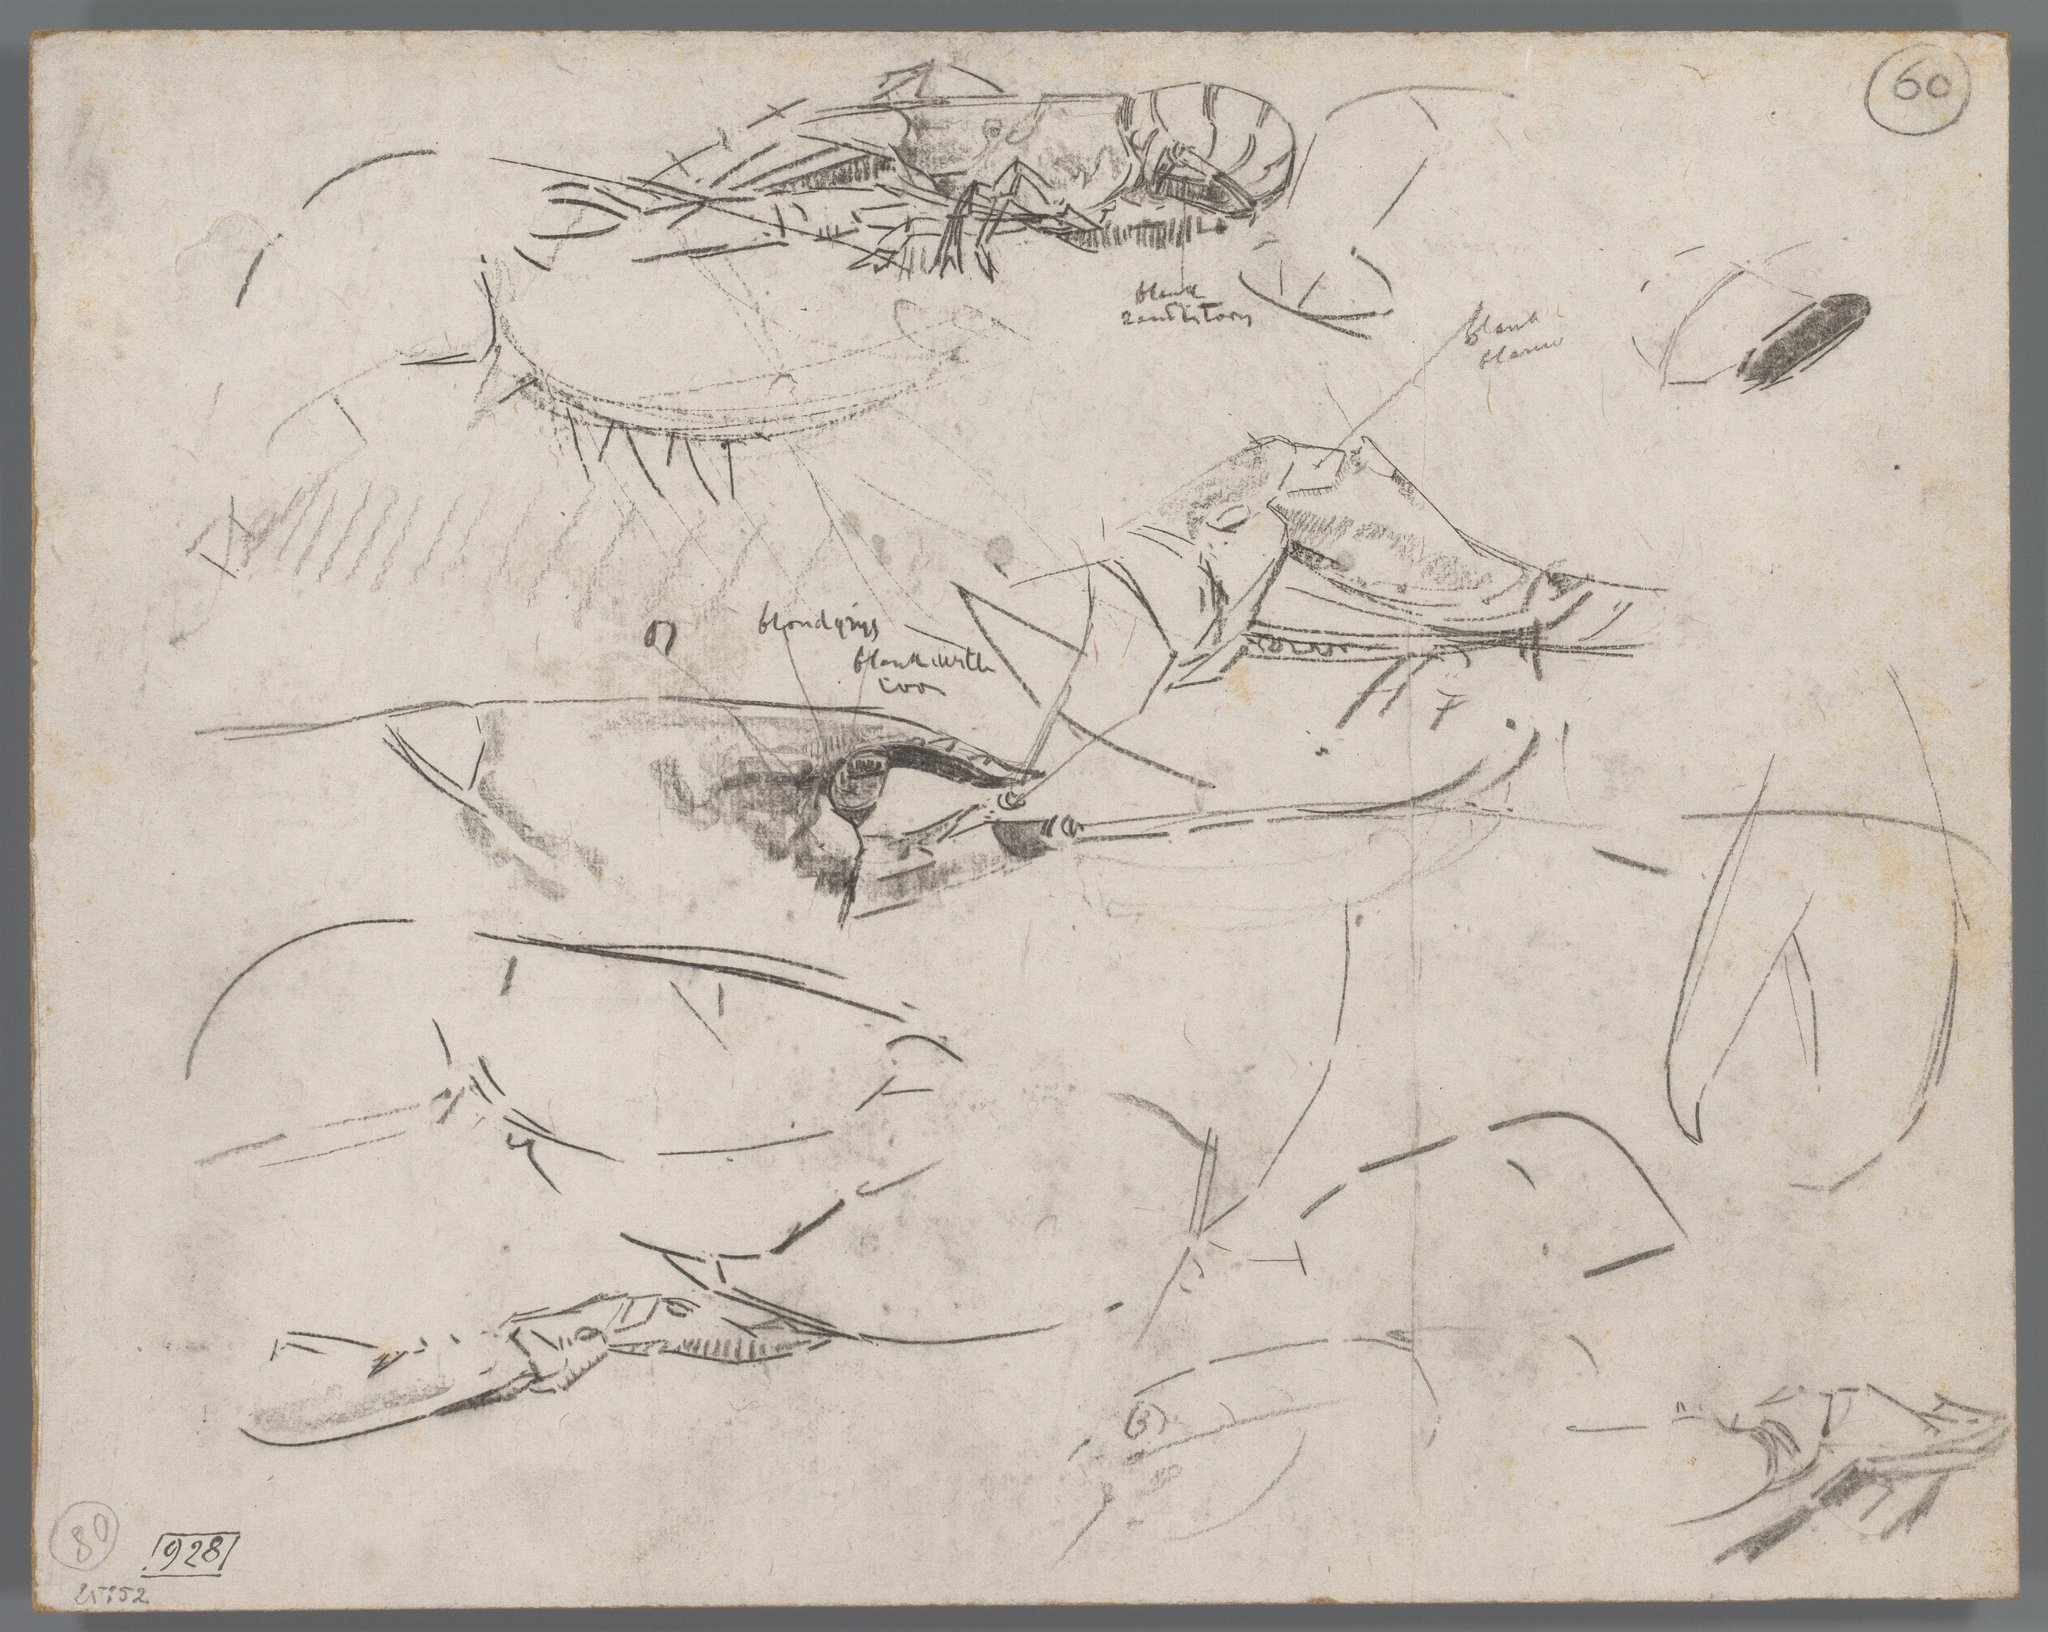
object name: drawing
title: Studies van lichaamsdelen van kreeften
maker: gerrit willem dijsselhof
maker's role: designer, draughtsman, print maker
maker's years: 1866-1924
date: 1876-1924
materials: cardboard, chalk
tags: crustaceans: lobster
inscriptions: number: ‘80’, number: ‘928’, number: ‘60’